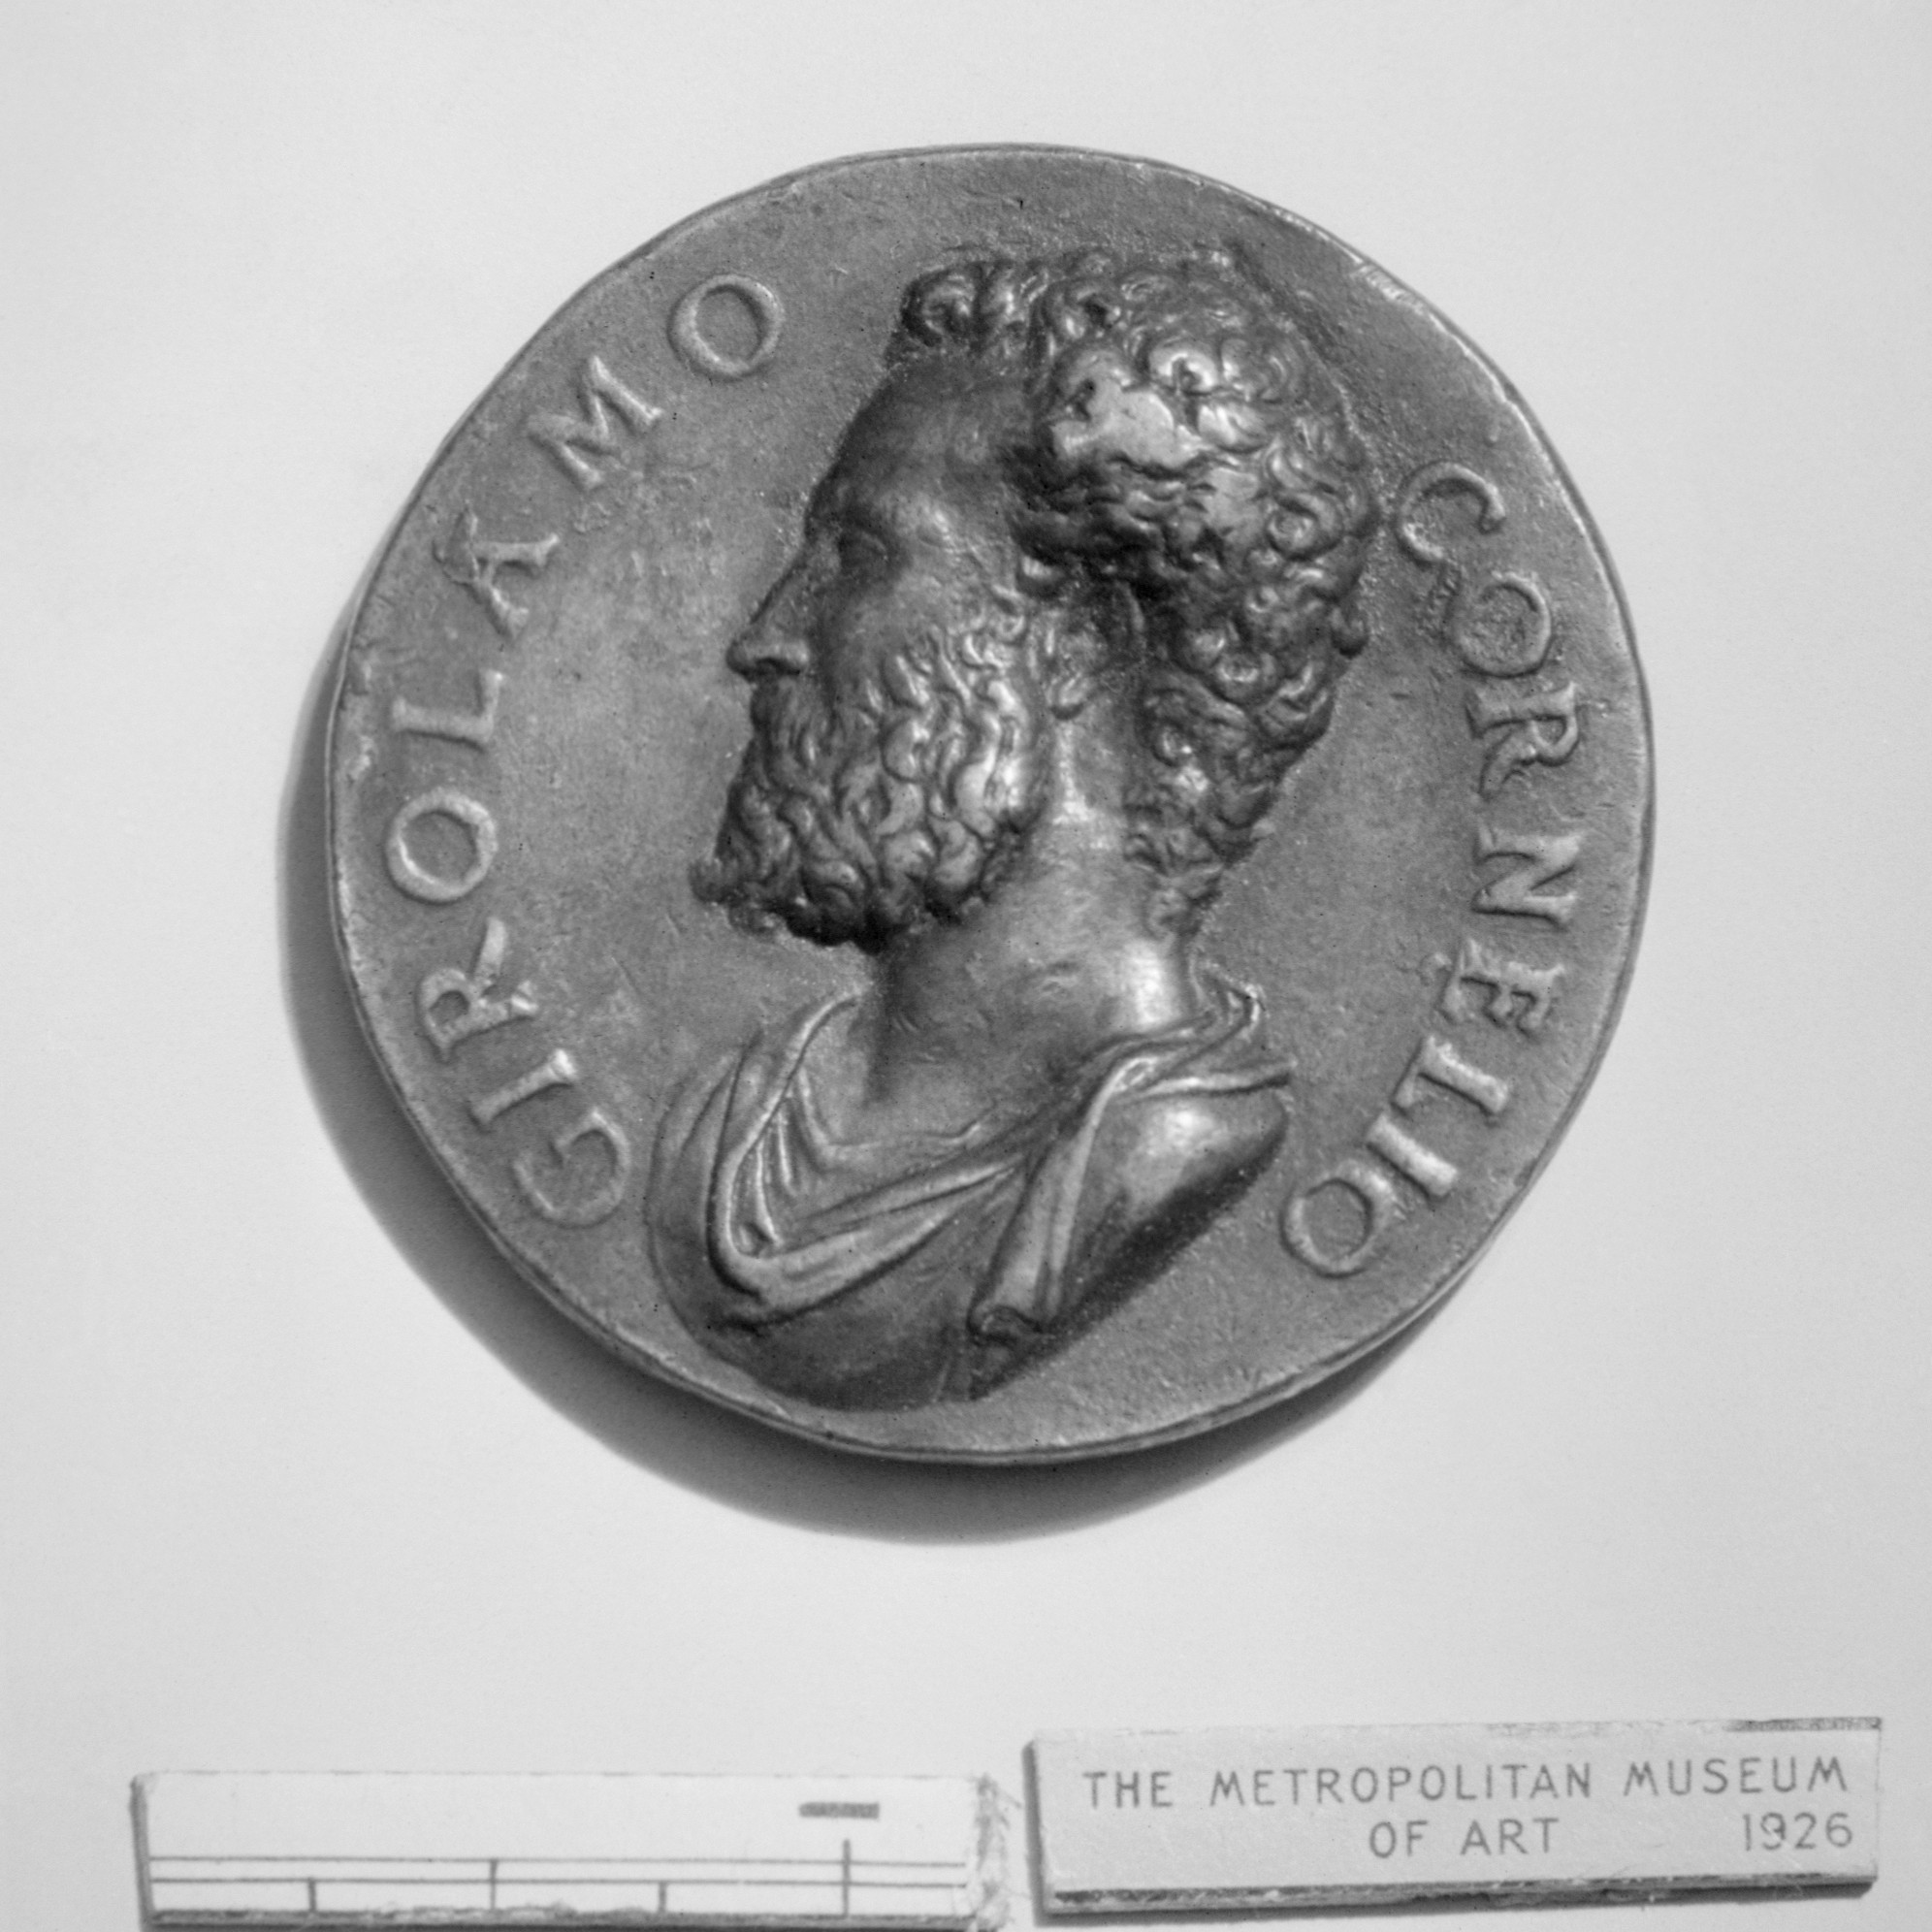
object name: medal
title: Girolamo Cornelio (Cornaro) and Helena, his wife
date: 1501-1600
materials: bronze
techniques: casting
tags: men,profiles